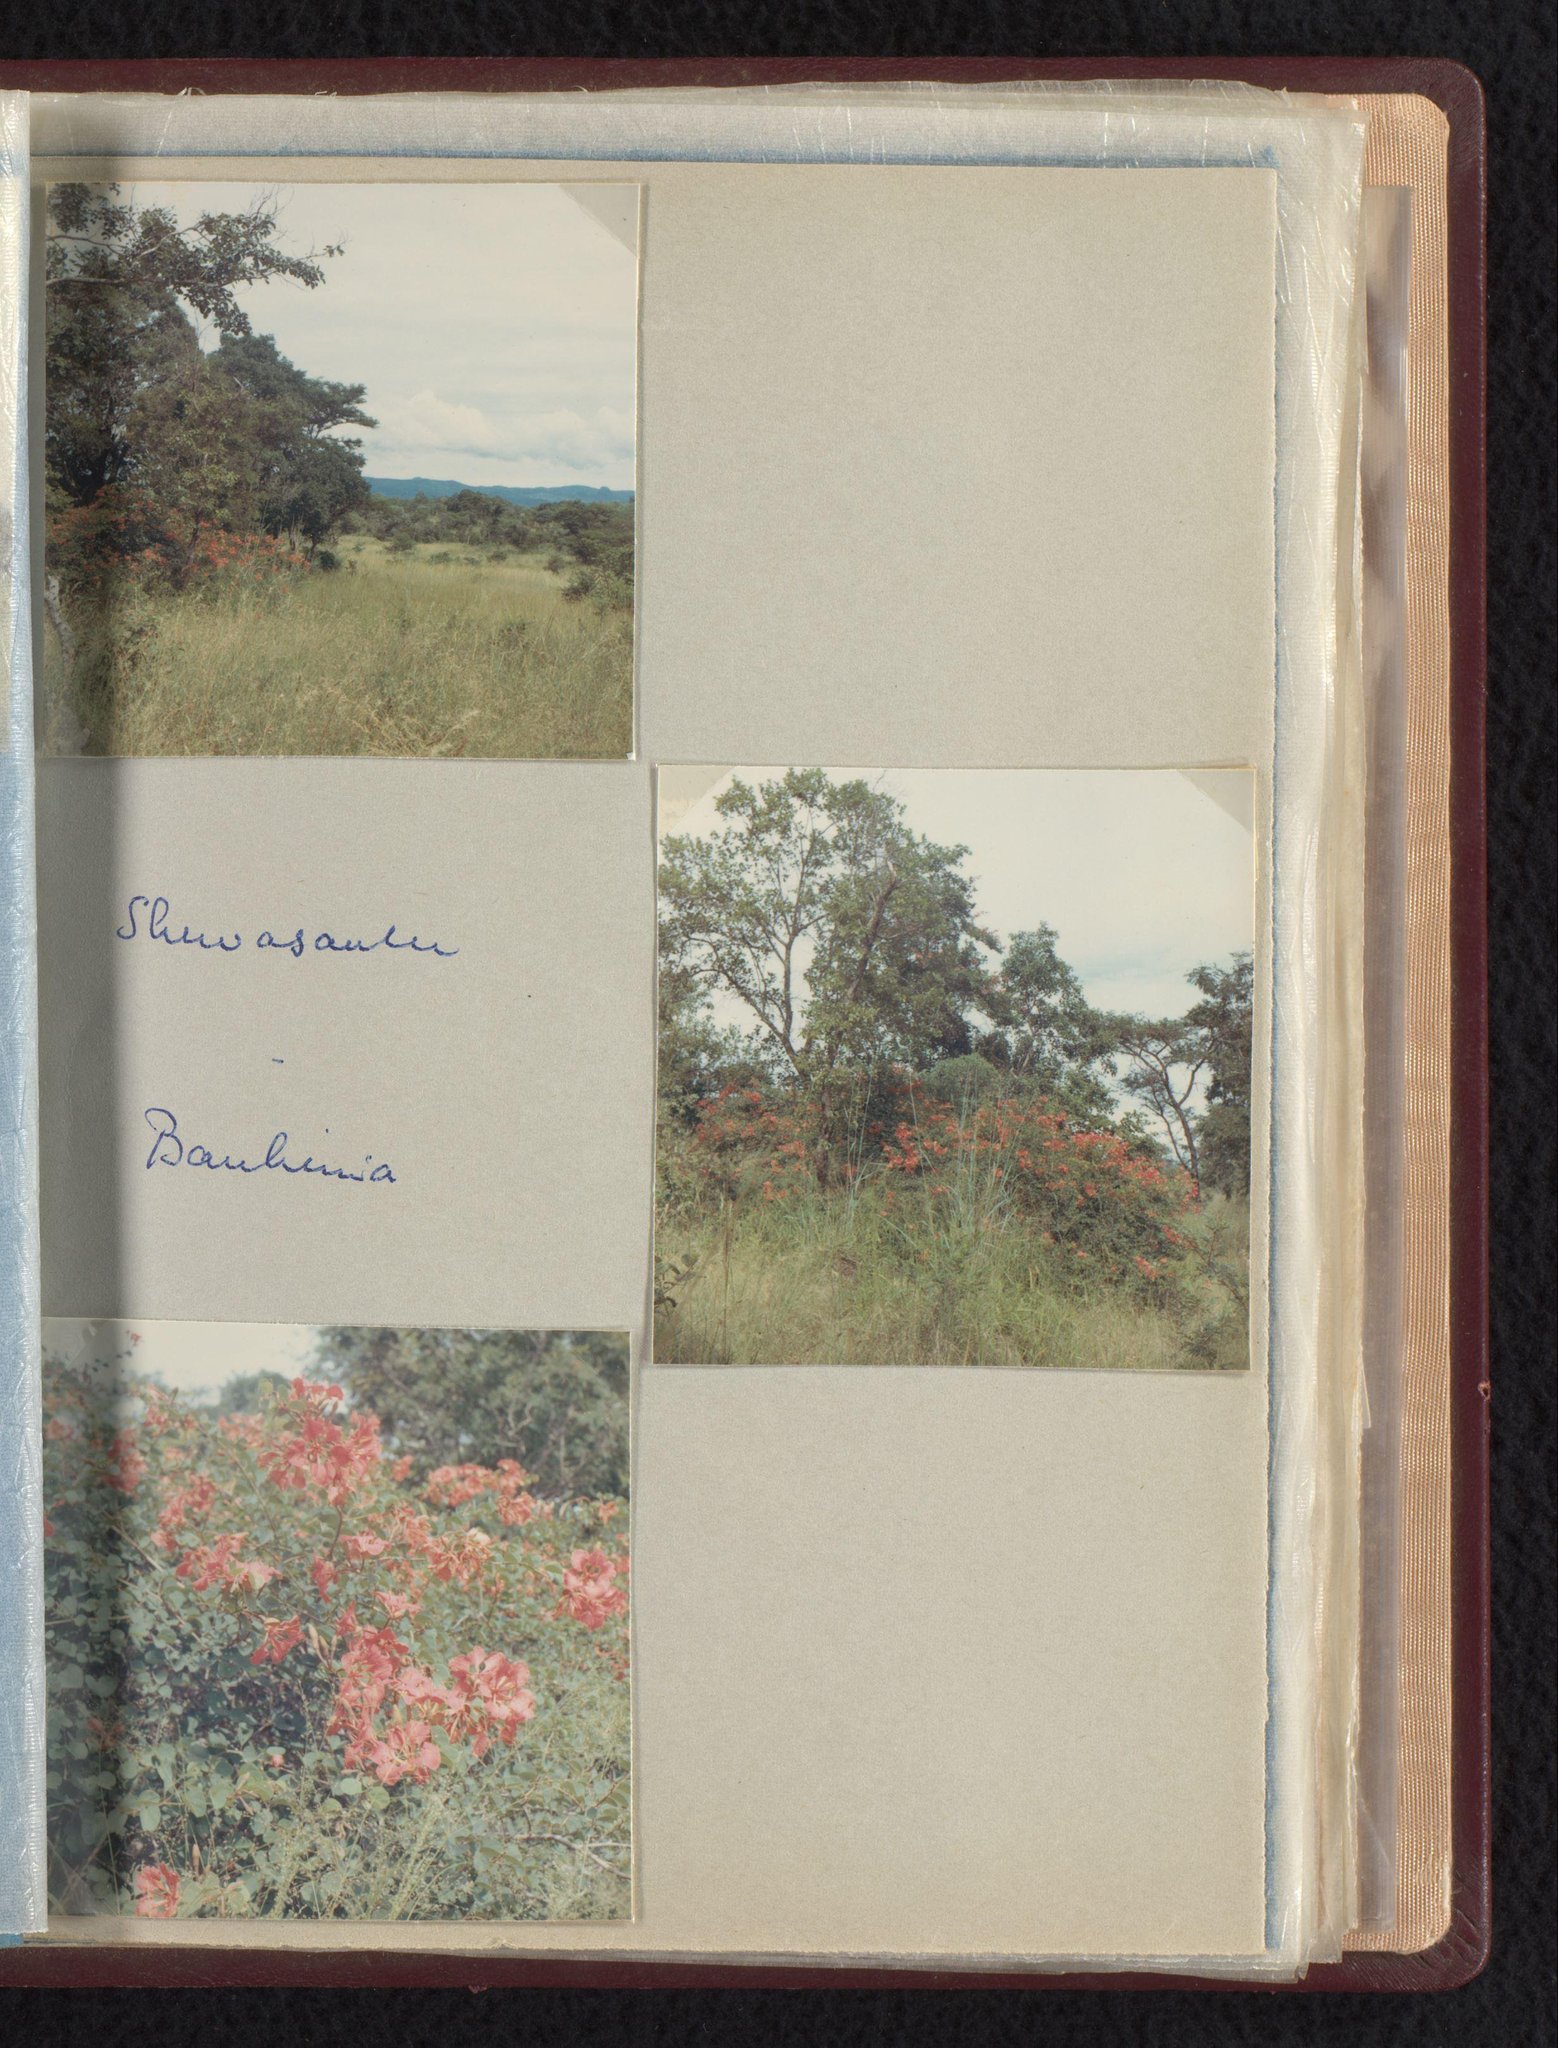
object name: album leaf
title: Shewasaulu, bauhinia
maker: willem jacob van den berg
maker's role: boer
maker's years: 1902-1983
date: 1967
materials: paper, cardboard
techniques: chromogenic print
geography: shewasaulu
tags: flowers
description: Deze foto's zijn onderdeel van een album.